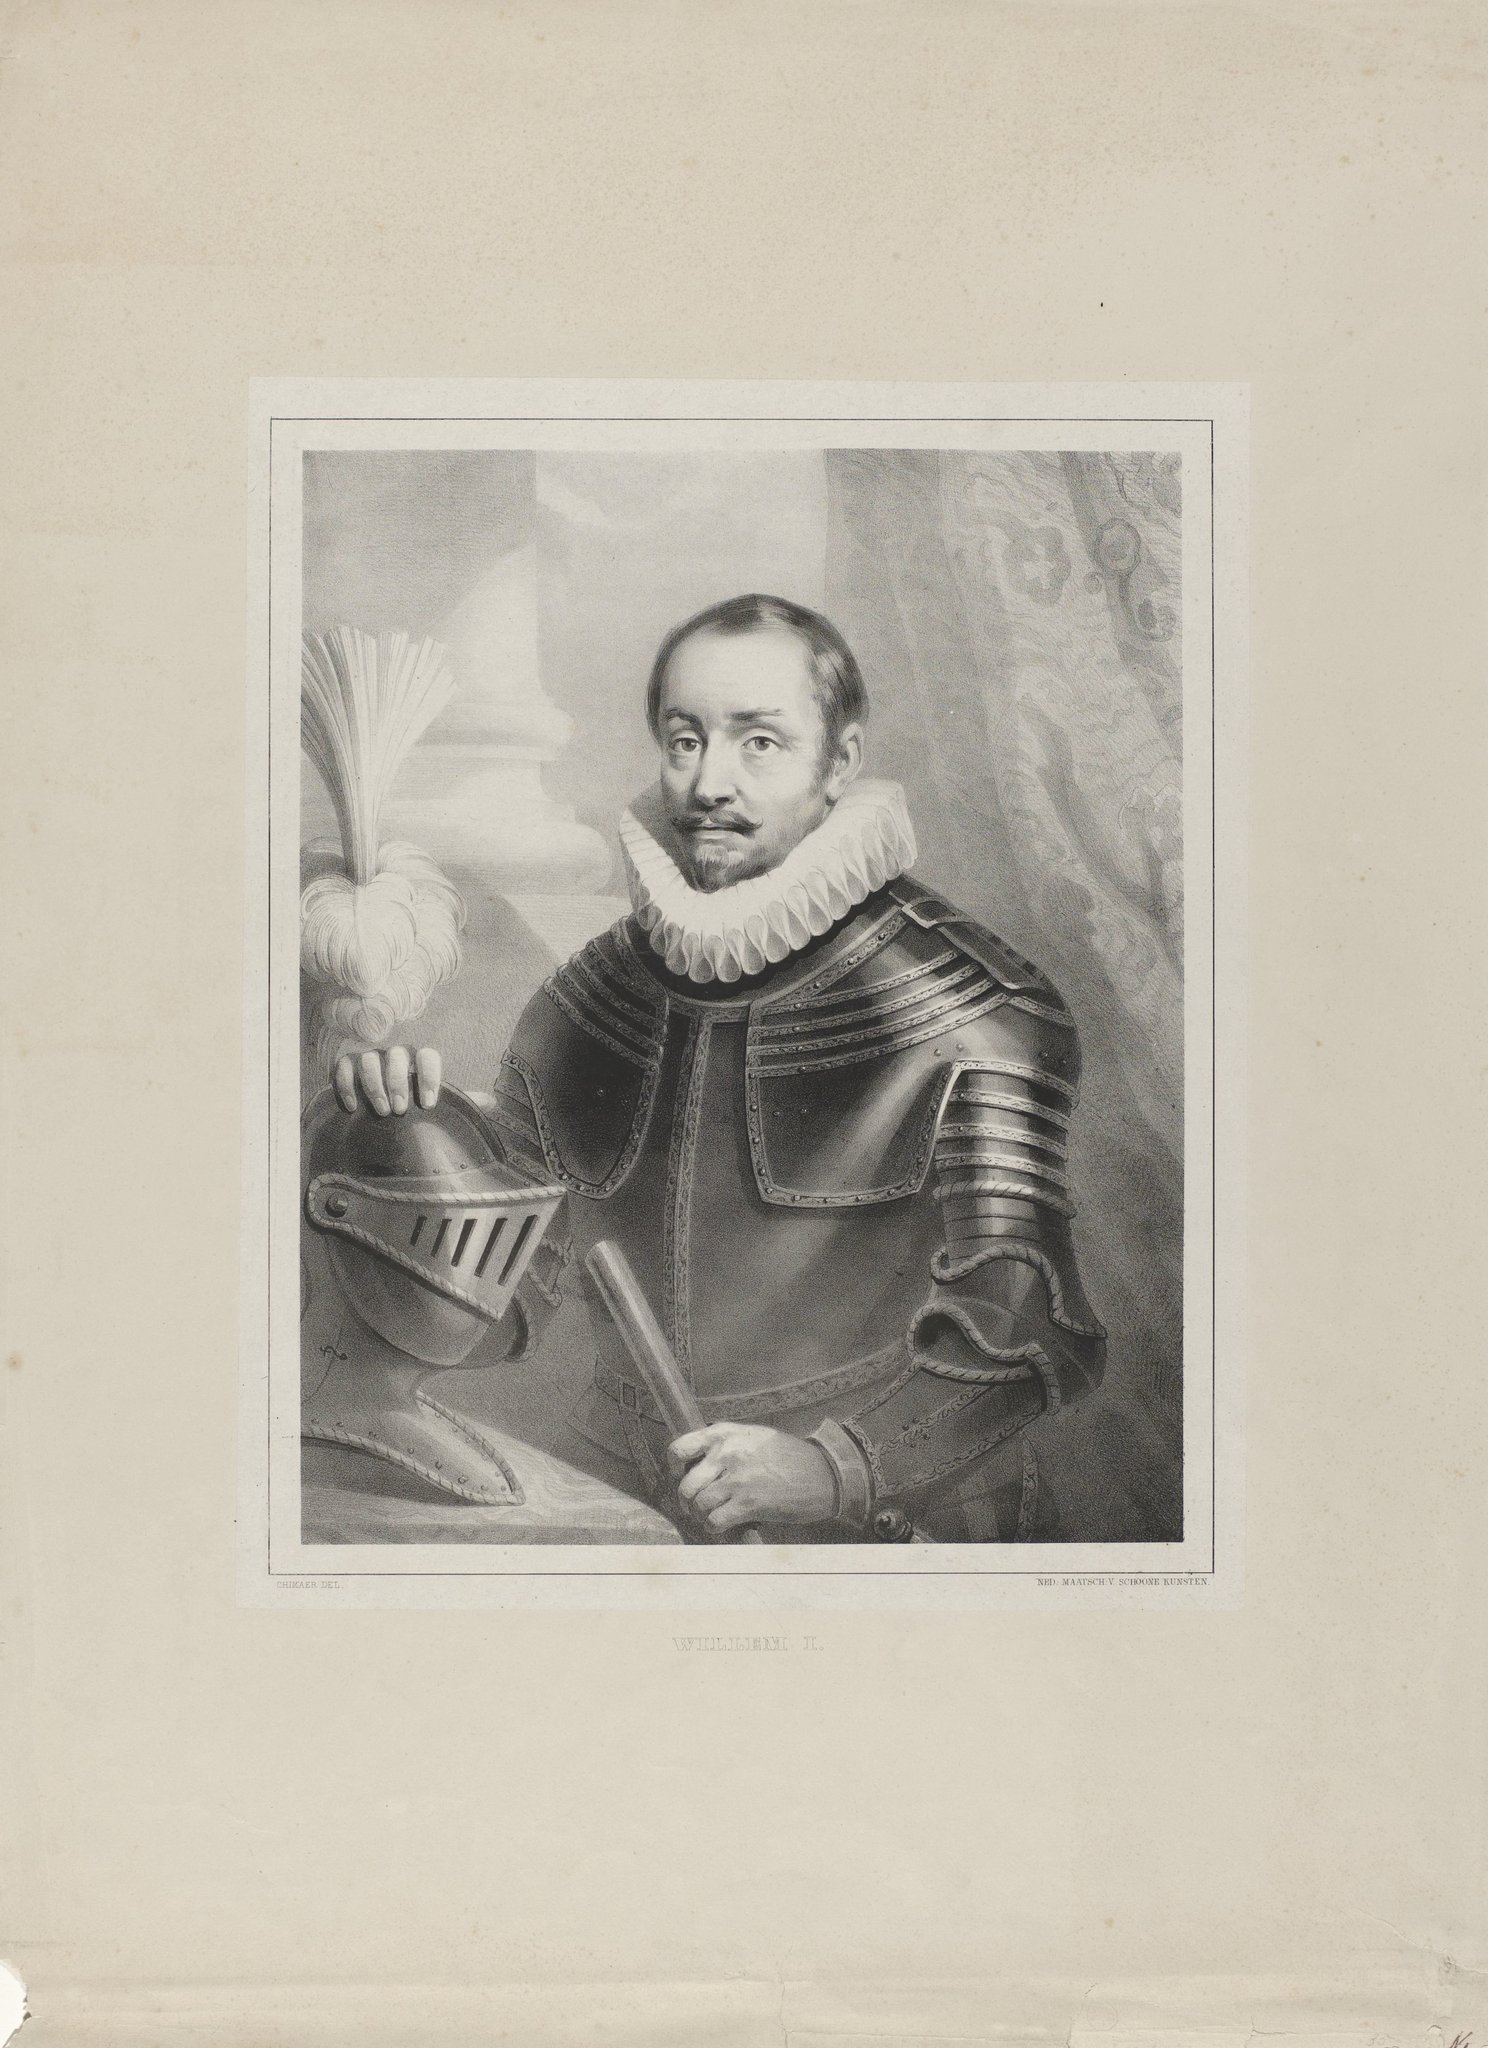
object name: print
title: Portret van Willem I, prins van Oranje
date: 1840-1843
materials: paper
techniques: lithograph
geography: the hague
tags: delft, william i (prince of orange)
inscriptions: collector's mark: Lugt 963, collector's mark: Lugt 2228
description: De hier vermelde titel verwijst naar de hoogst verkregen titel van de geportretteerde, niet per se naar de titel die de geportretteerde op deze voorstelling draagt.